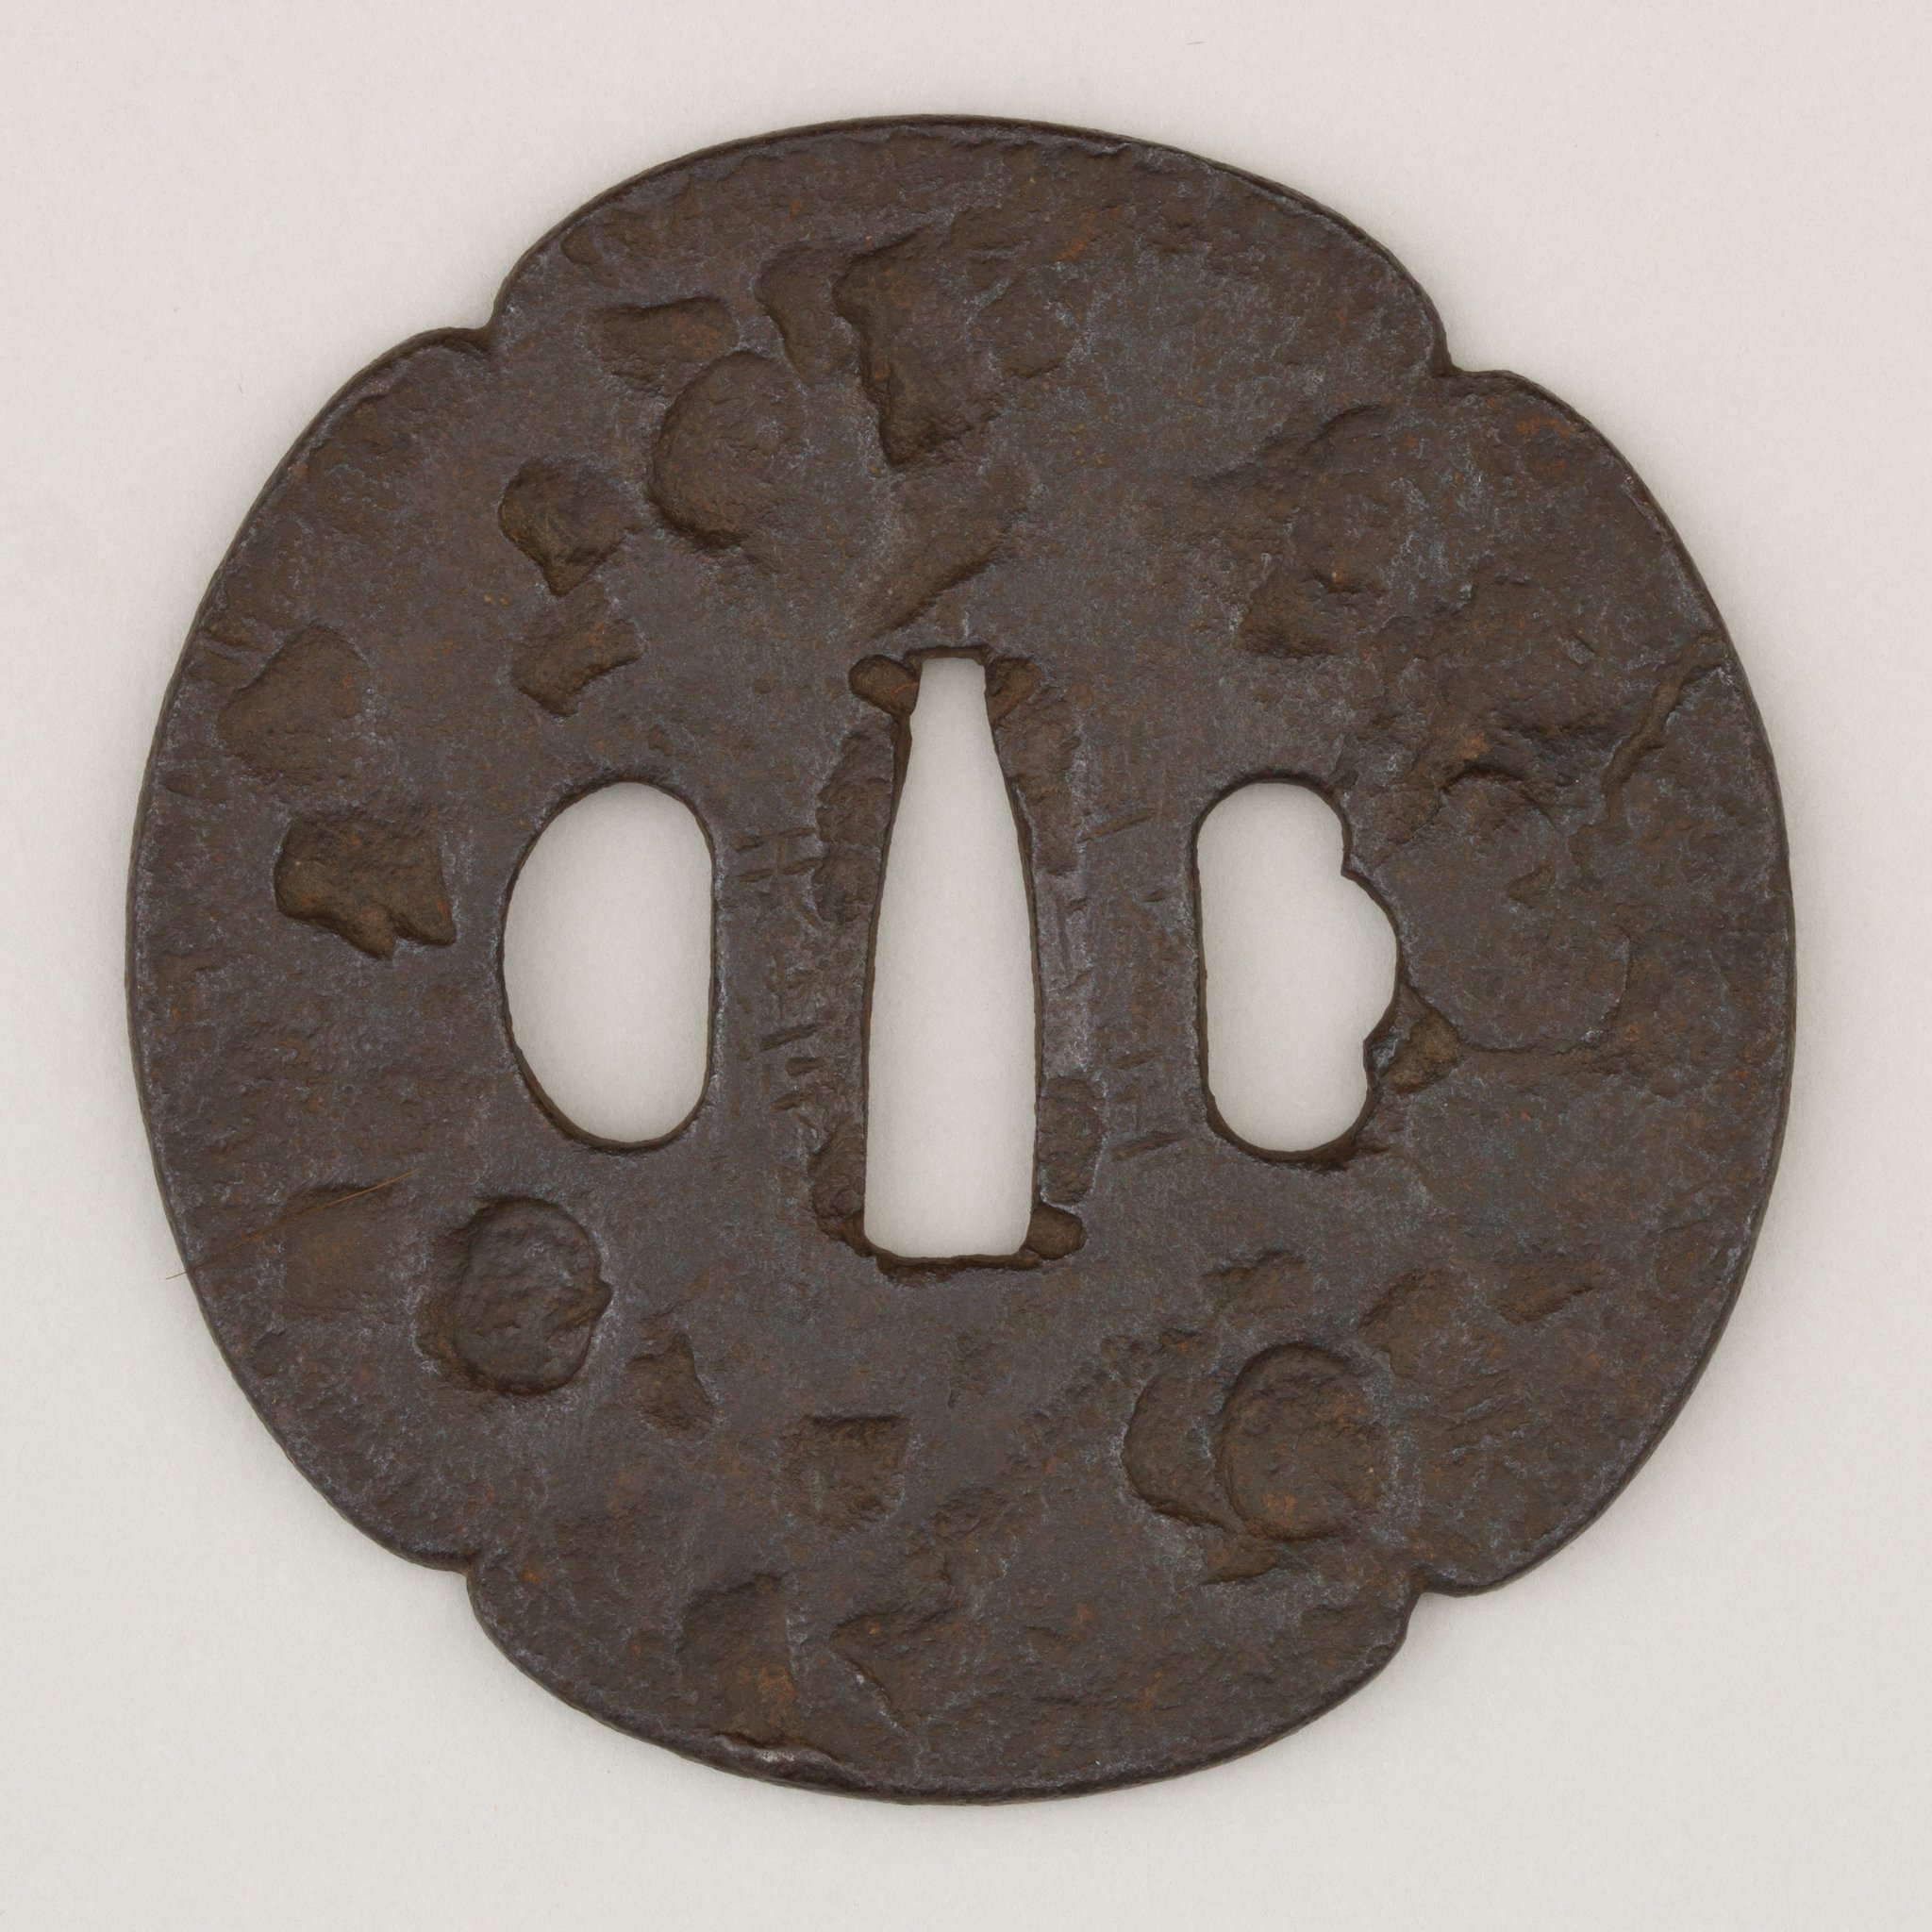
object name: sword guard tsuba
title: Sword Guard (Tsuba)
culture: japanese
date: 1701-1800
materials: copper, iron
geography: japan